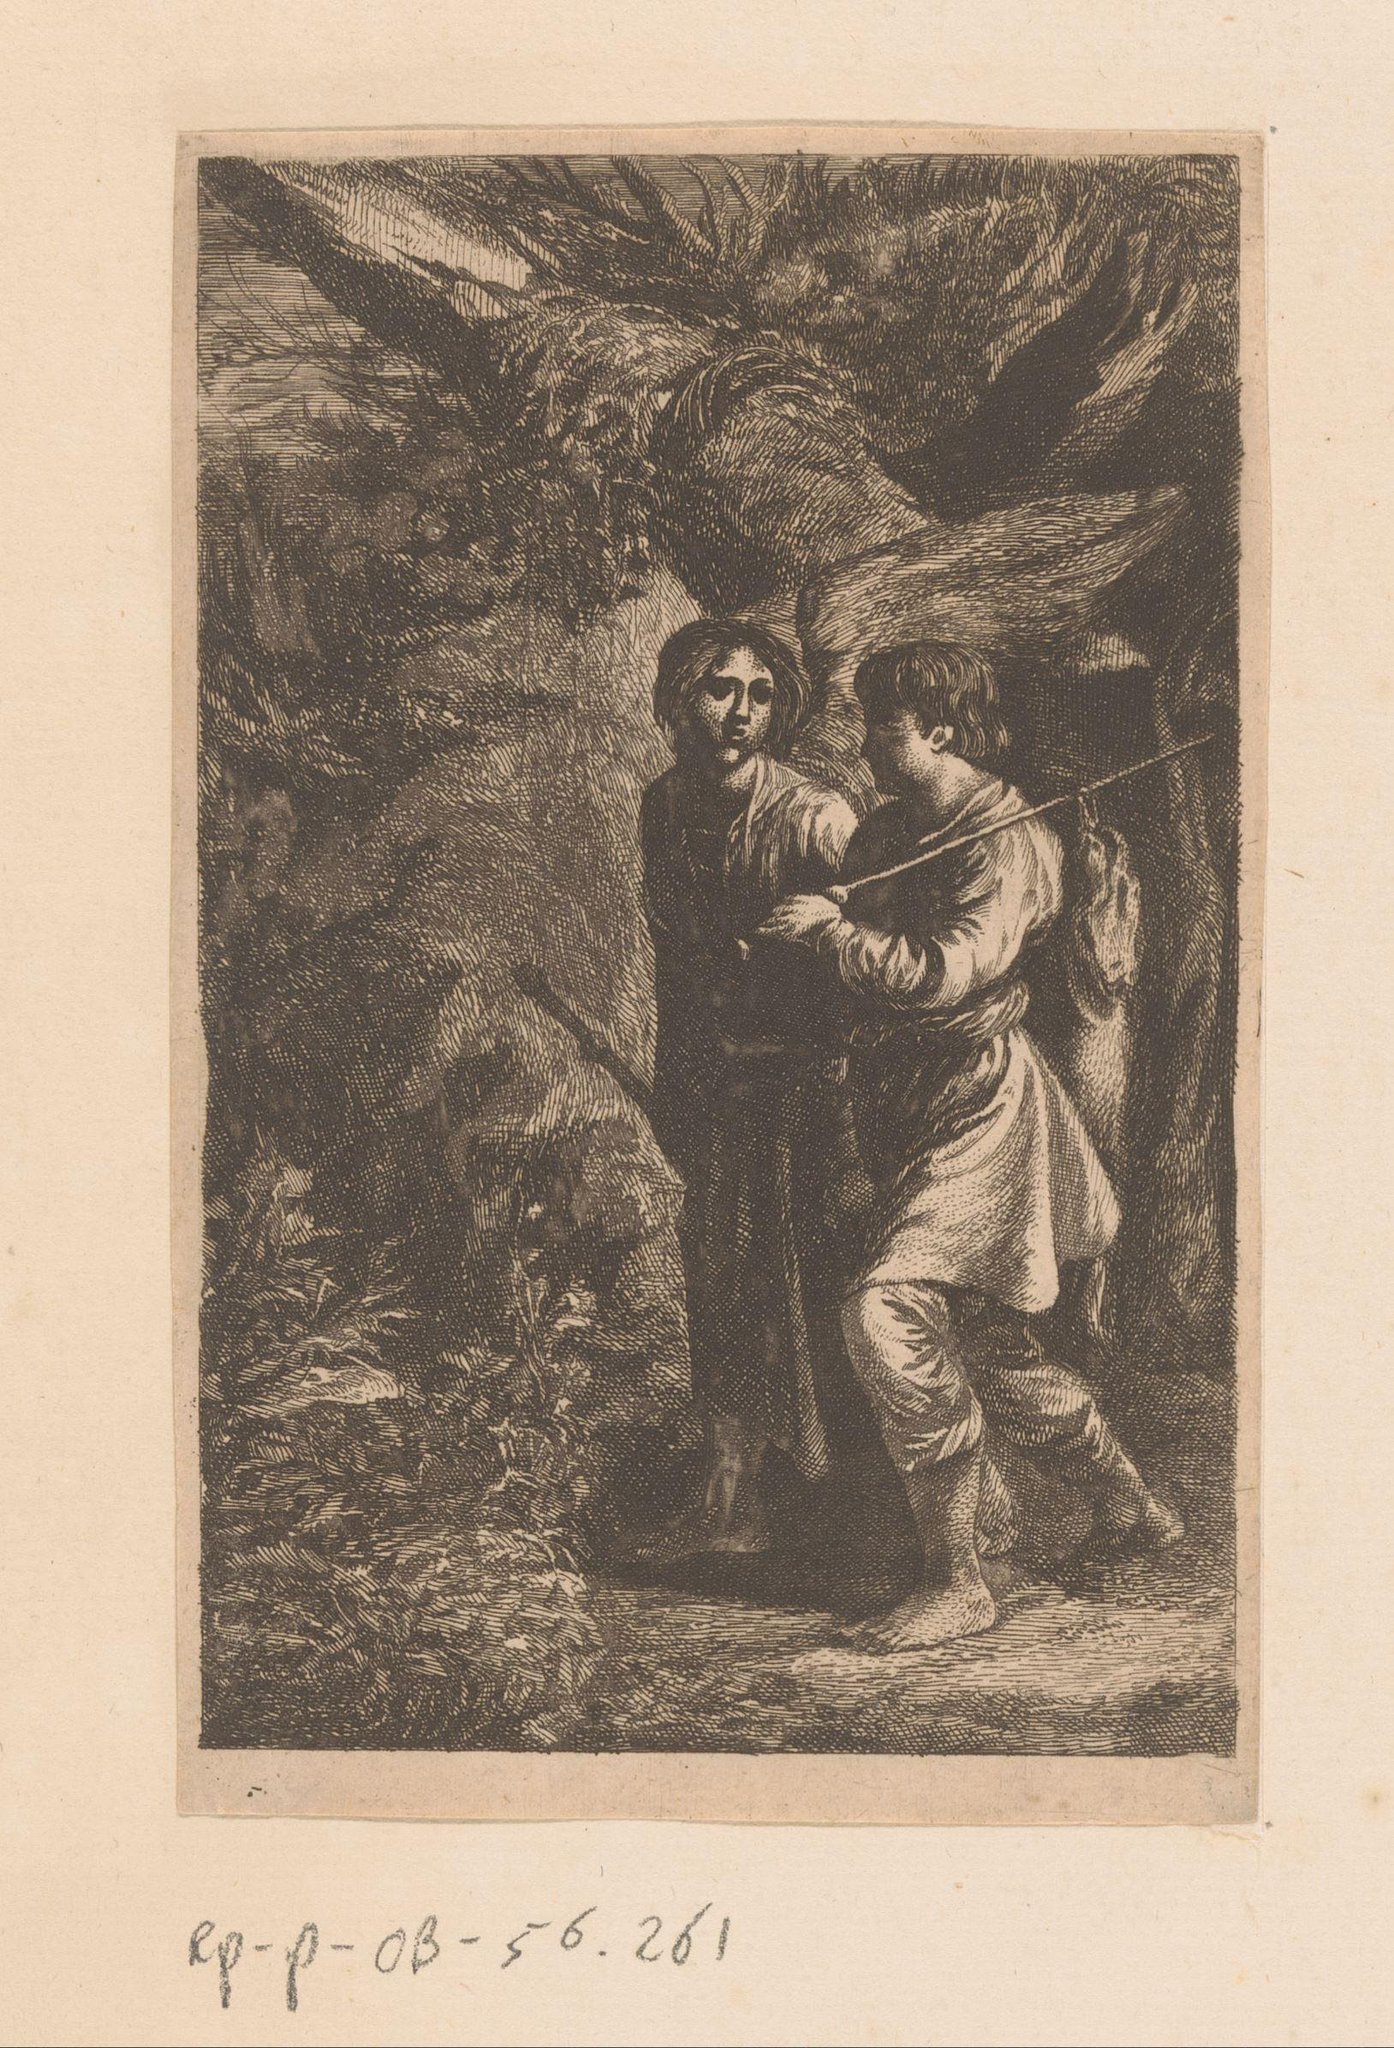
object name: print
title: Tobias en de engel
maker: Anonymous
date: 1588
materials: paper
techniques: etching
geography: germany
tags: tobias and the angel raphael travelling, accompanied by tobias' dog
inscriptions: collector's mark: Lugt 240